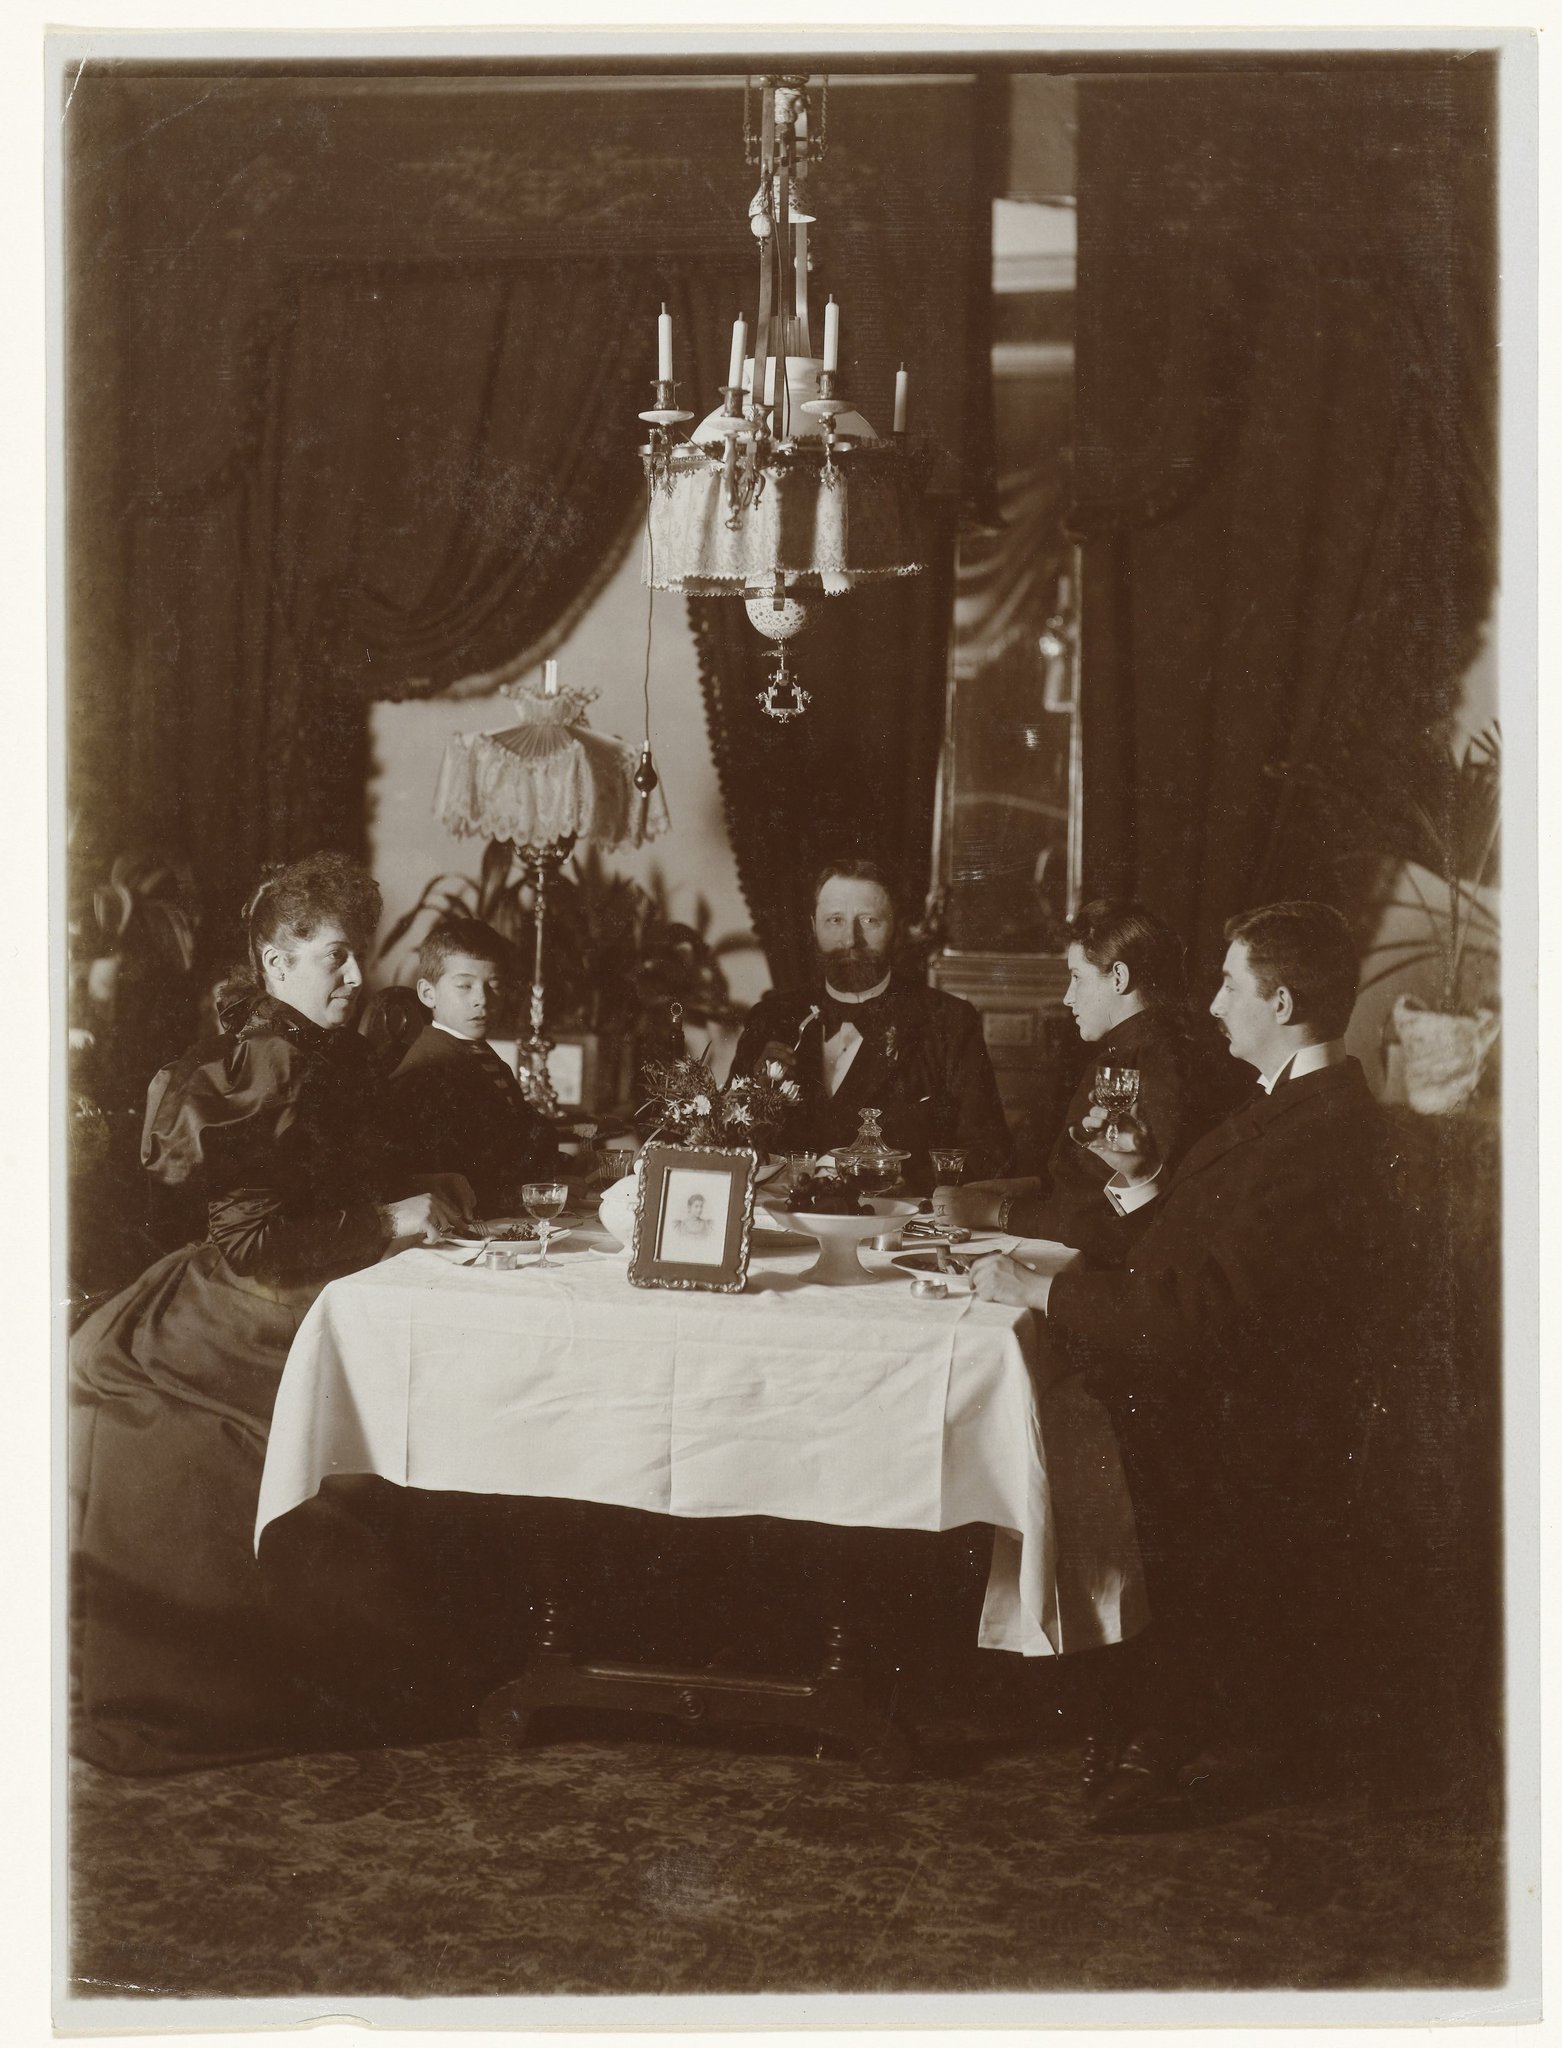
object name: photograph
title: Familie aan tafel, met een fotoportret in lijst op de tafel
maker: henri osieck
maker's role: fotograaf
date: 1897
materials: paper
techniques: collodion silver print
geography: netherlands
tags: family group, especially parents with their child(ren), netherlands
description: Fotolijst in zwart op tafel op een prominente plaats duidt vaak op een pas overleden of een voor langere tijd afwezig persoon.